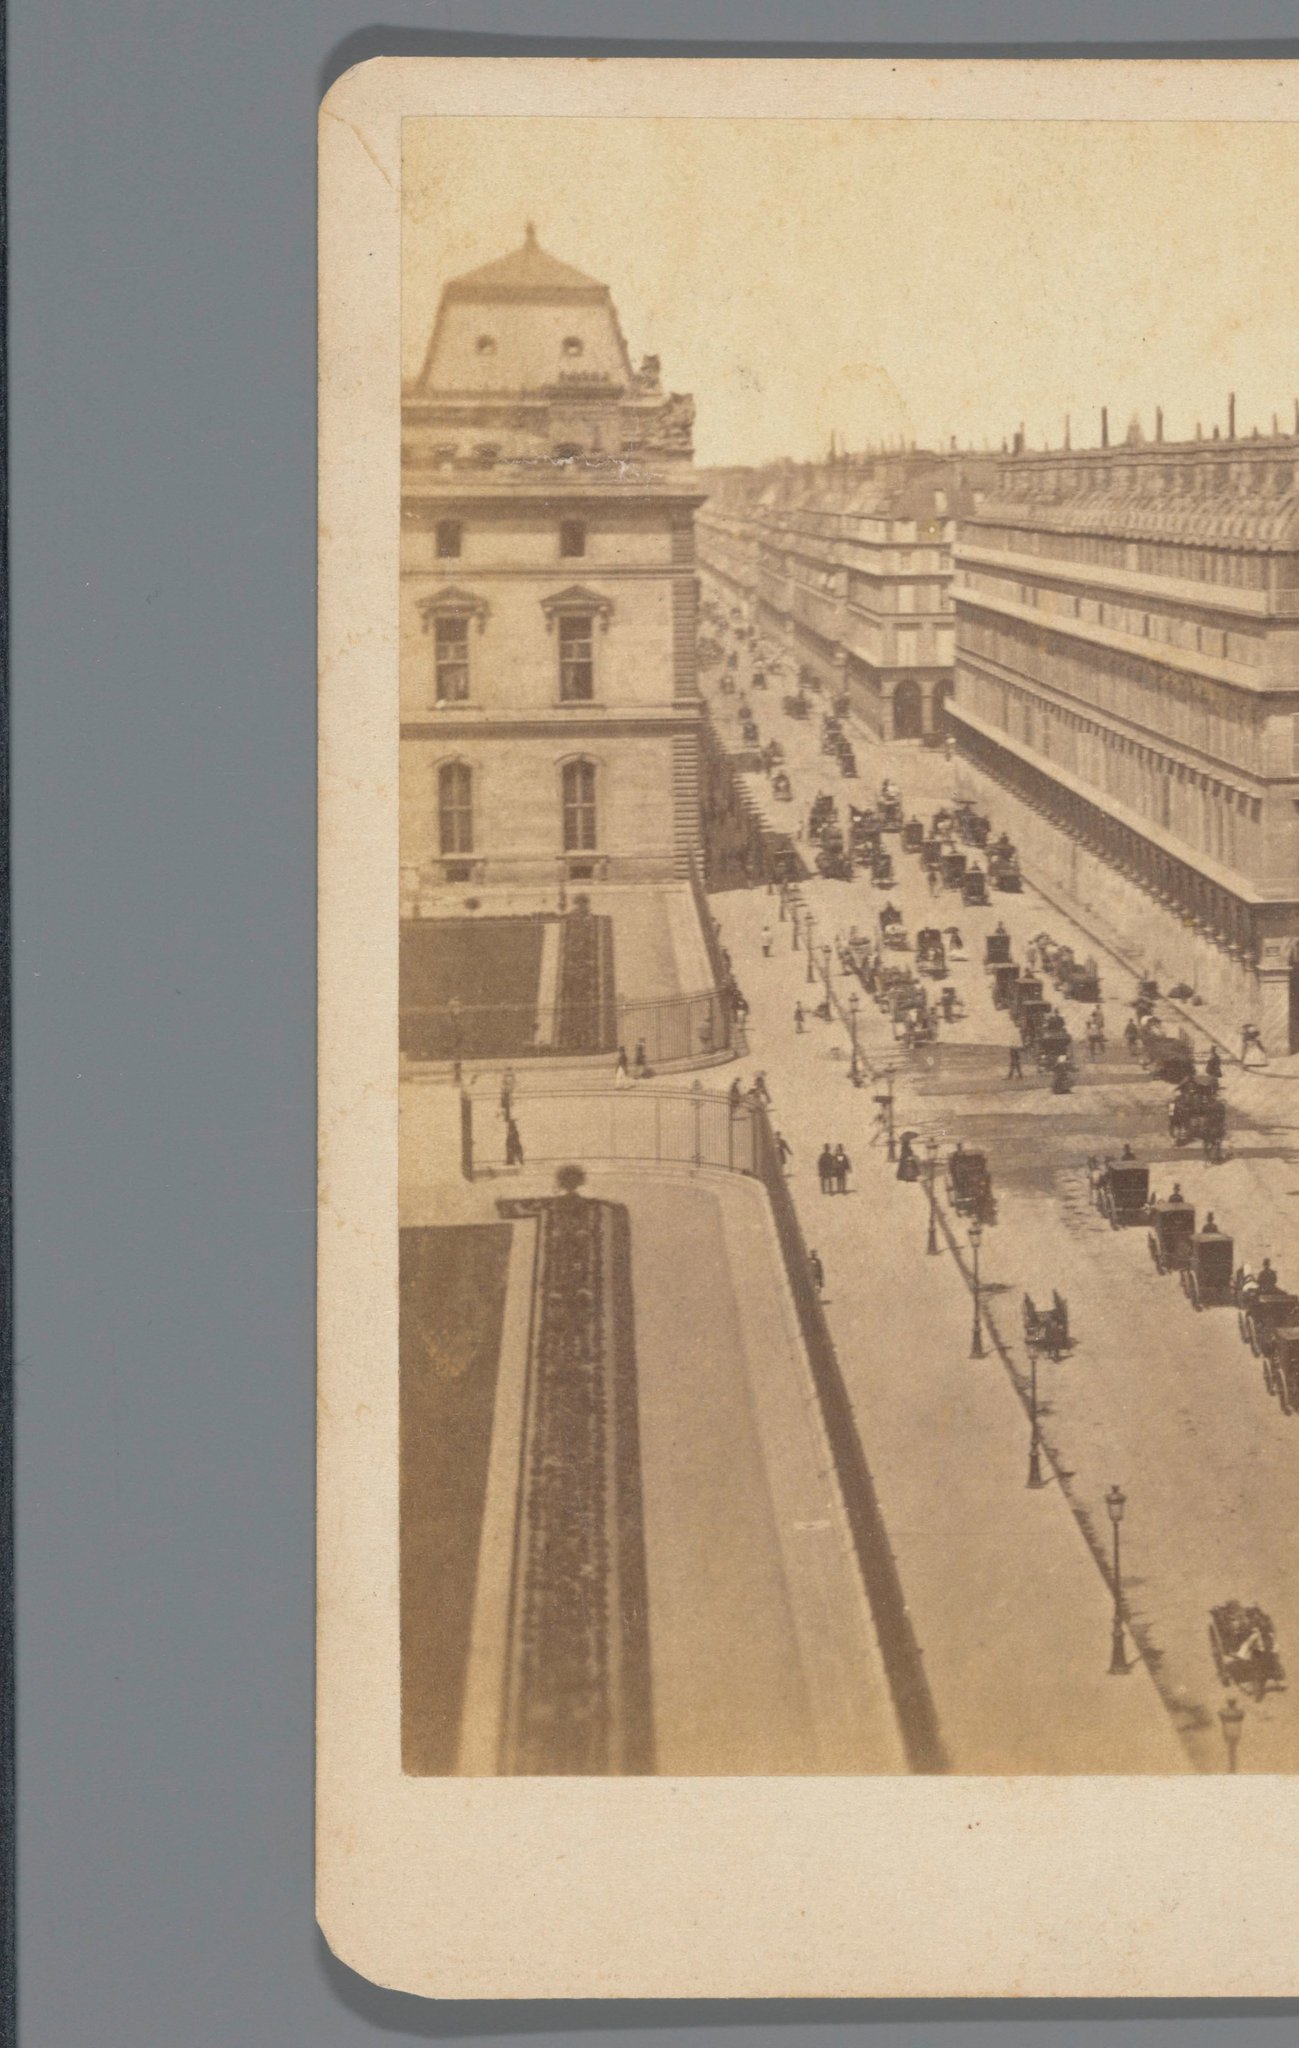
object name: carte de visite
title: Straatgezicht van de Rue de Rivoli, Parijs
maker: Anonymous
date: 1865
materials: cardboard, paper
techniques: albumen print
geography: paris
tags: urban housing, street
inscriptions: inscription: ‘rue de rivoli’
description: Carte-de-visite, zogenaamde instantanée, met vroeg straatgezicht van de Rue de Rivoli te Parijs, met rijdende koetsen en lopende mensen.